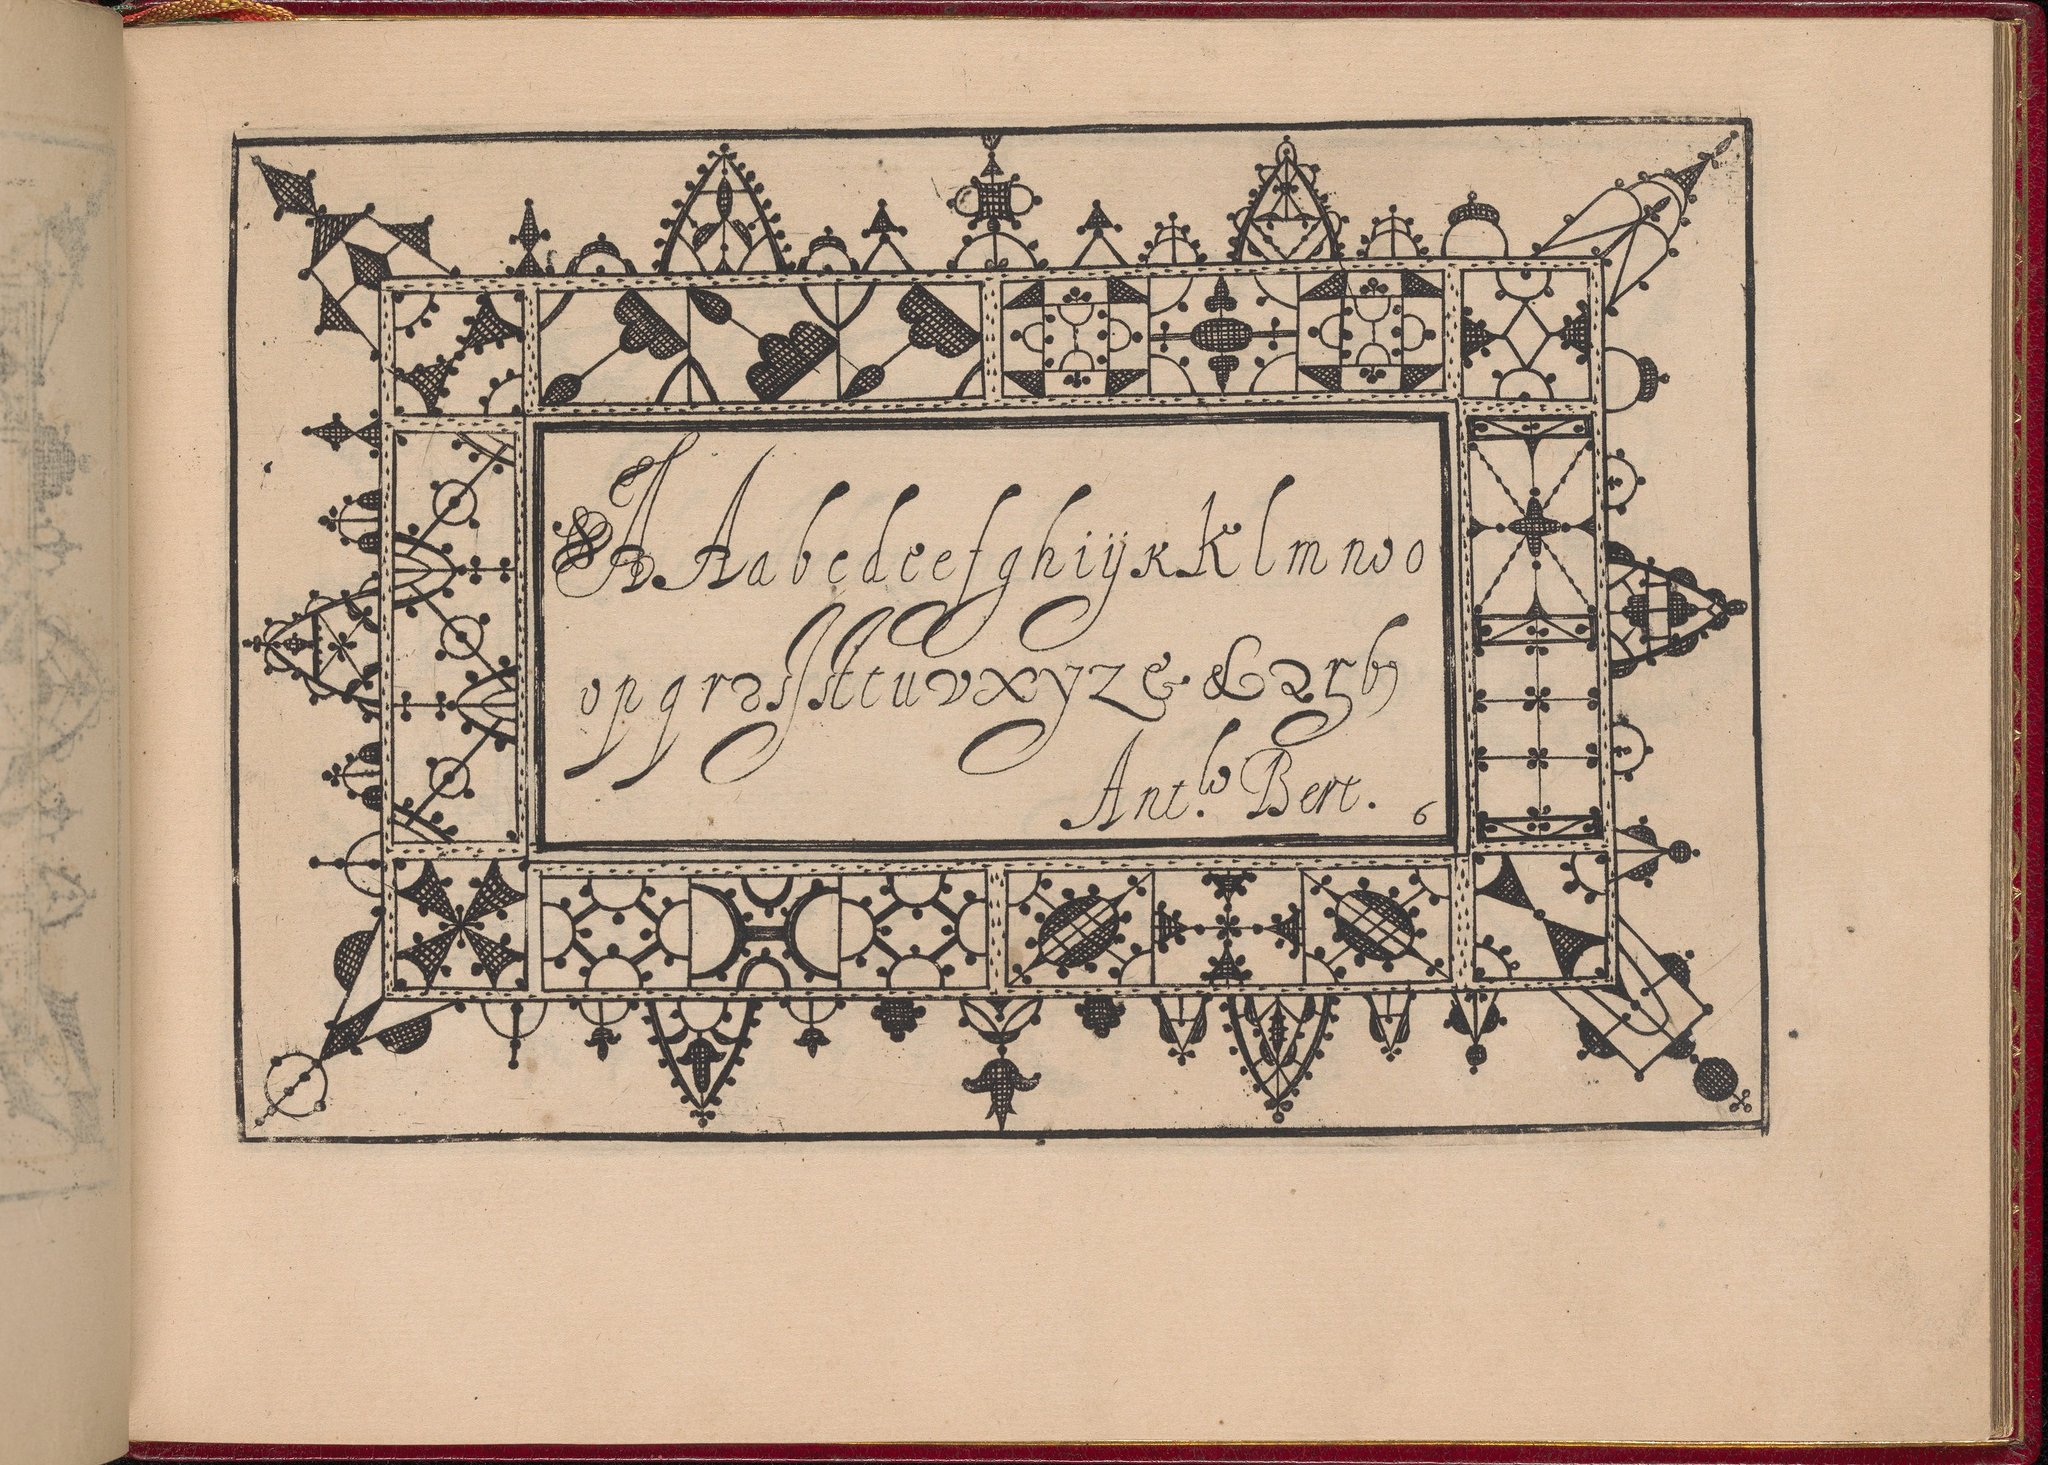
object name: book print ornament architecture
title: Ghirlanda: Di sei vaghi fiori scielti da piu famosi Giardini d'Italia, page 14 (recto)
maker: pietro paulo tozzi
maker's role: designer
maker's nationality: italian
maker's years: 1593-1628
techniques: drawing, etching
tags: ornament